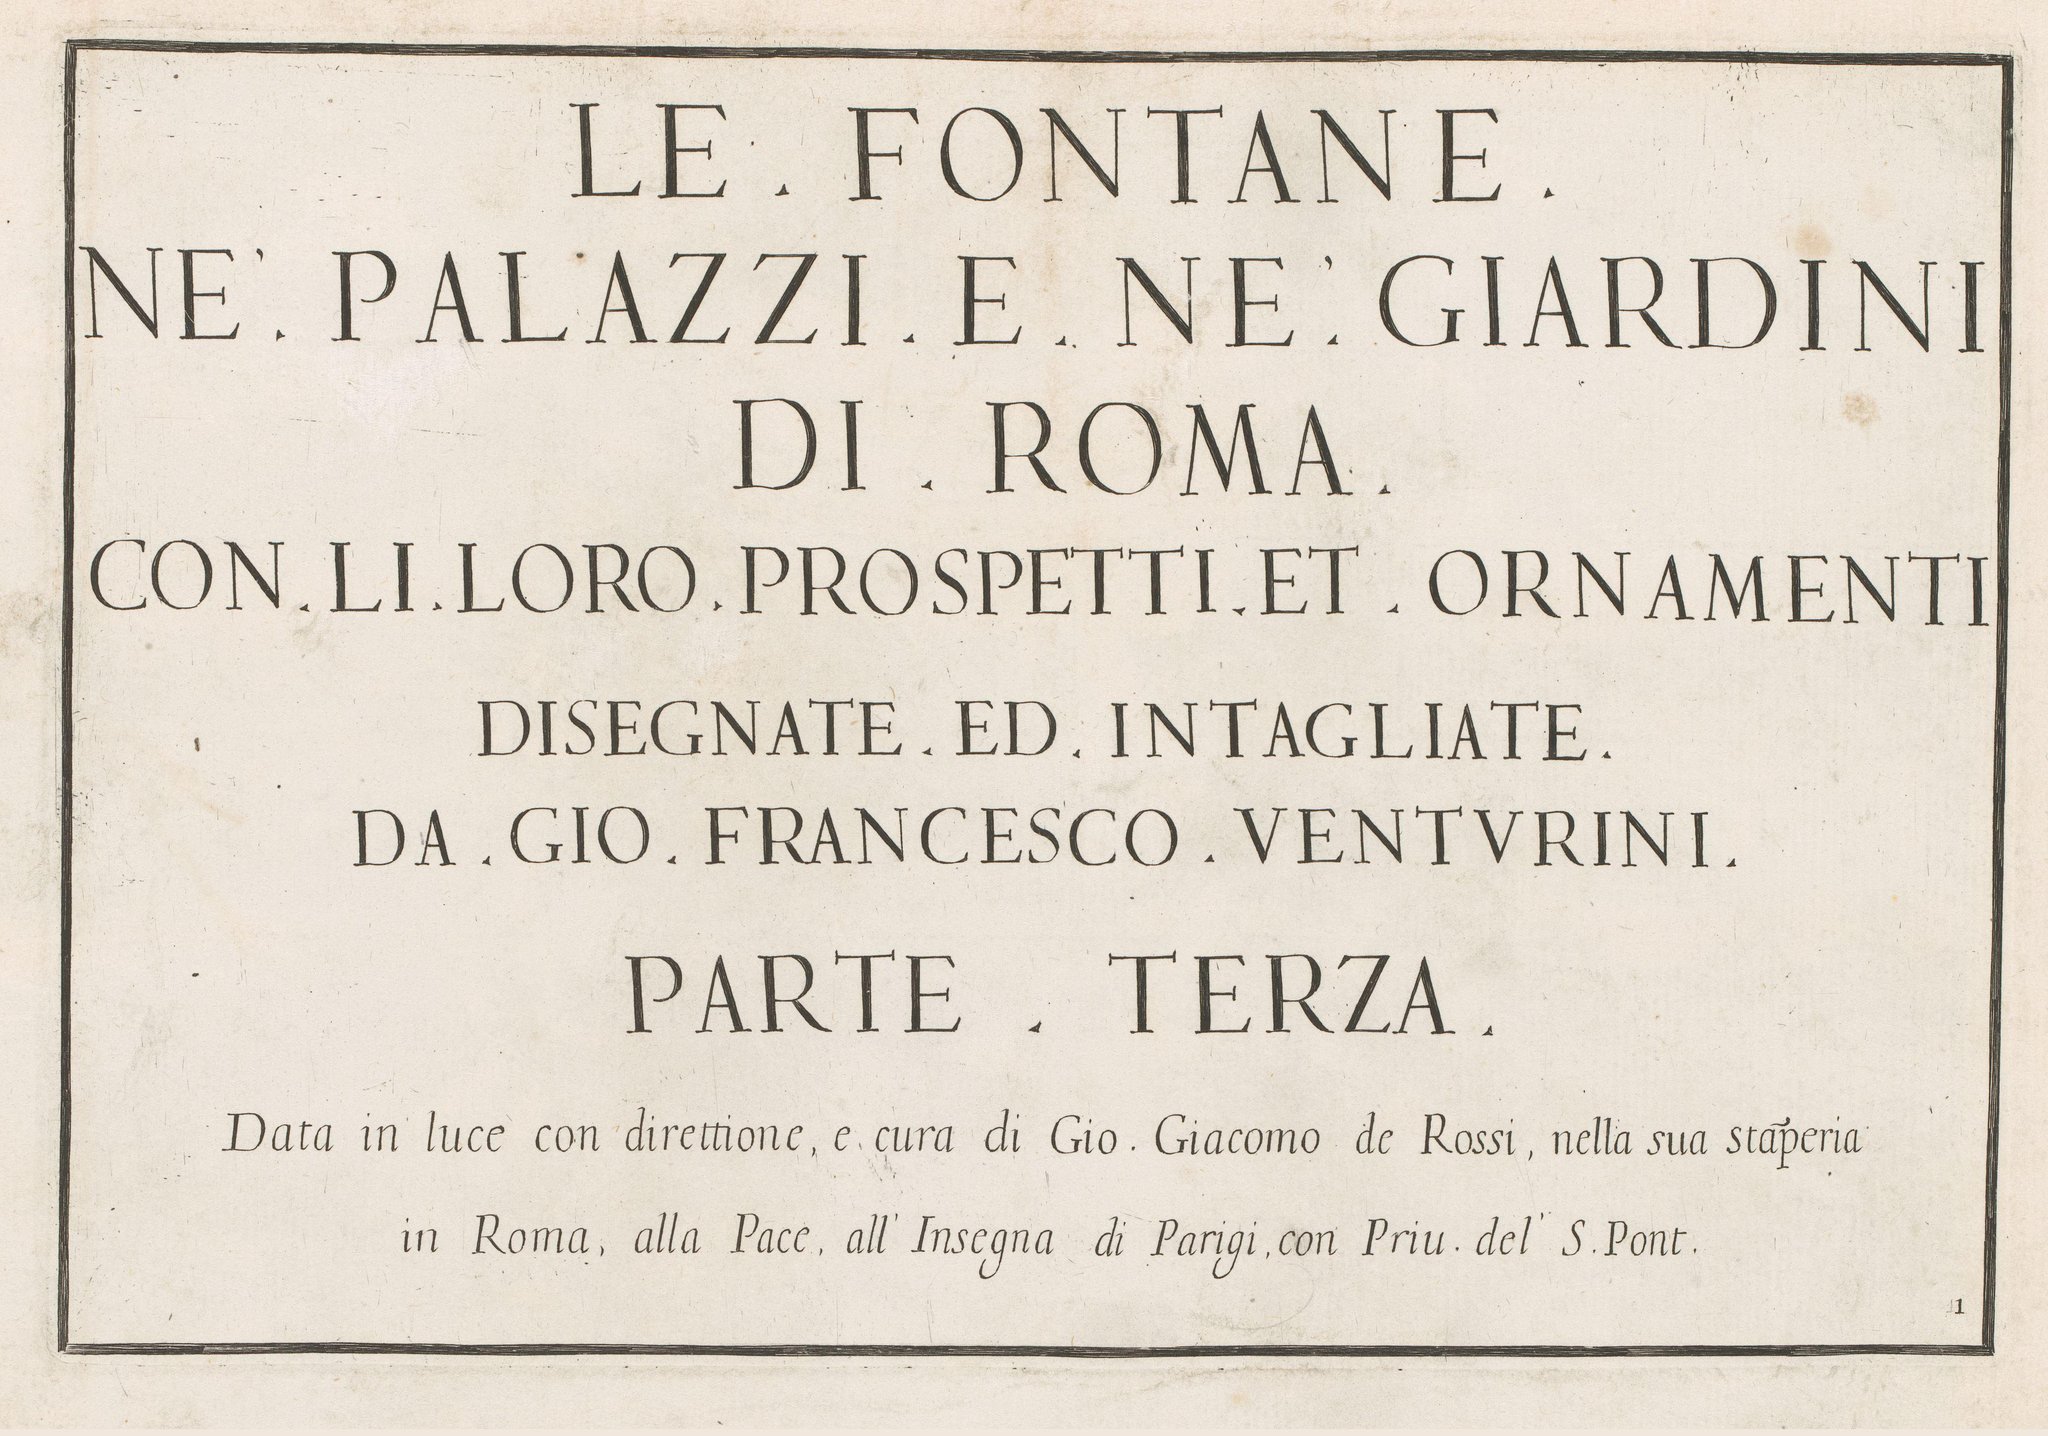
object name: album leaf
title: Fonteinen in de paleizen en tuinen van Rome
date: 1653-1691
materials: paper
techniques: etching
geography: vatican city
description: Genummerd rechtsonder: 1. De prent maakt deel uit van een album.